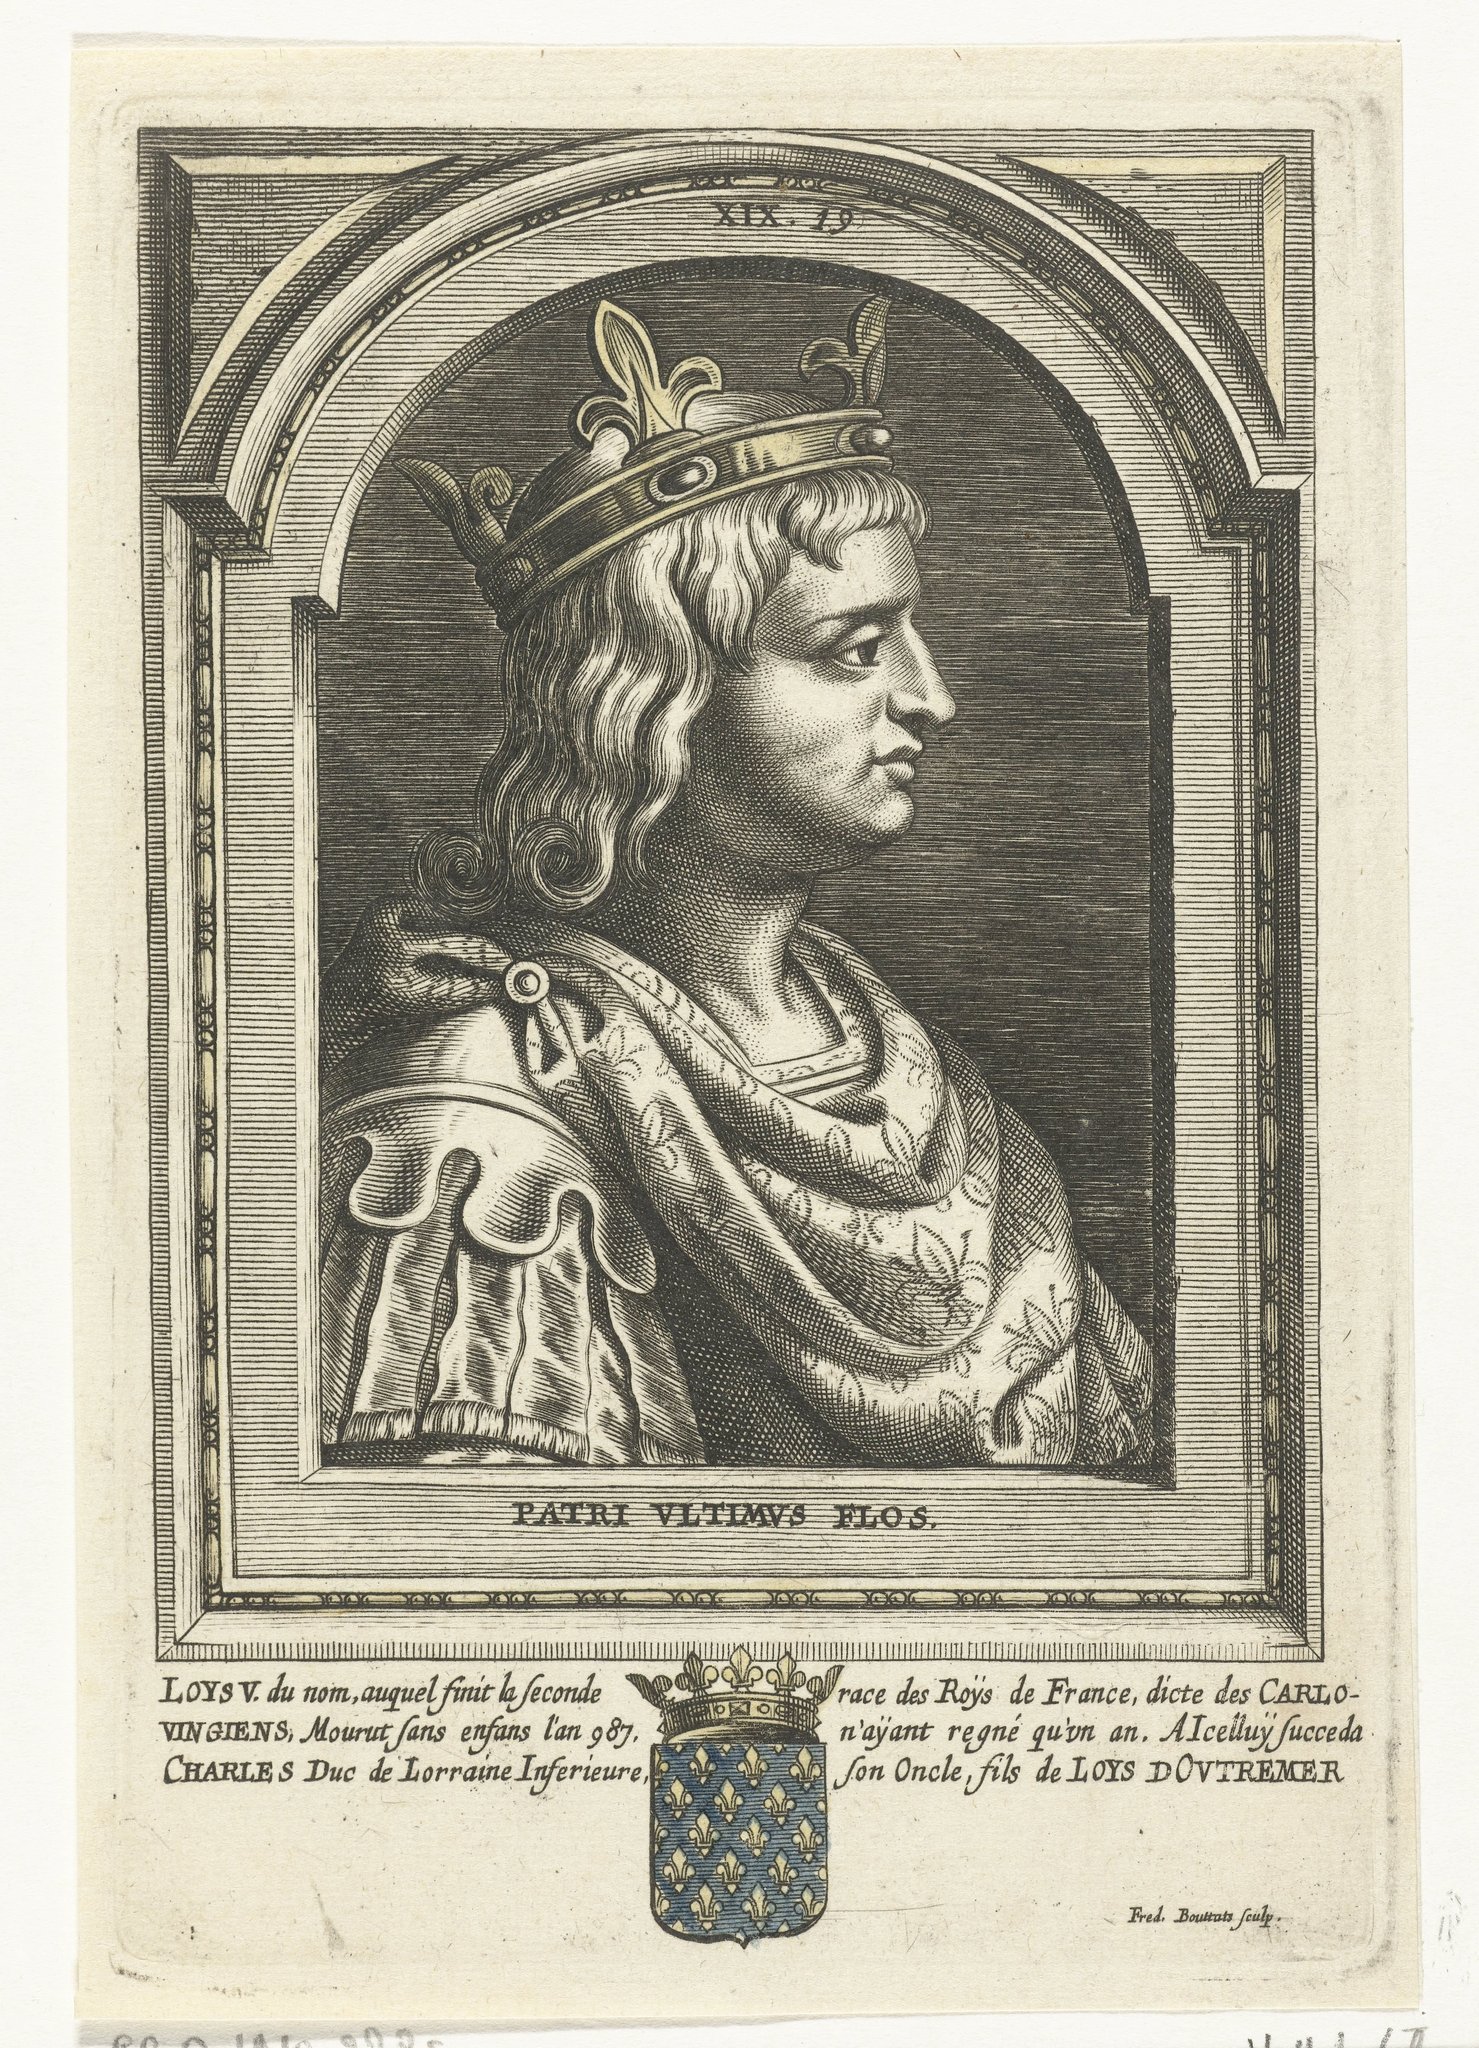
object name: print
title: Portret van Lodewijk V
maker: frederik bouttats (i)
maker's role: artist, painter, print maker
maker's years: 1590-1661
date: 1600-1676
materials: paper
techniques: engraving, hand coloring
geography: antwerp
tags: compiègne, koning, lodewijk v (koning van west-francië)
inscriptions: collector's mark: Lugt 2228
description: Portret in boogvormige nis. Lodewijk V, koning van Frankrijk. Buste naar rechts. Lodewijk V draagt een mantel met de Franse lelie. De prent heeft een Frans onderschrift met de naam van de geportretteerde en wat informatie over zijn leven.